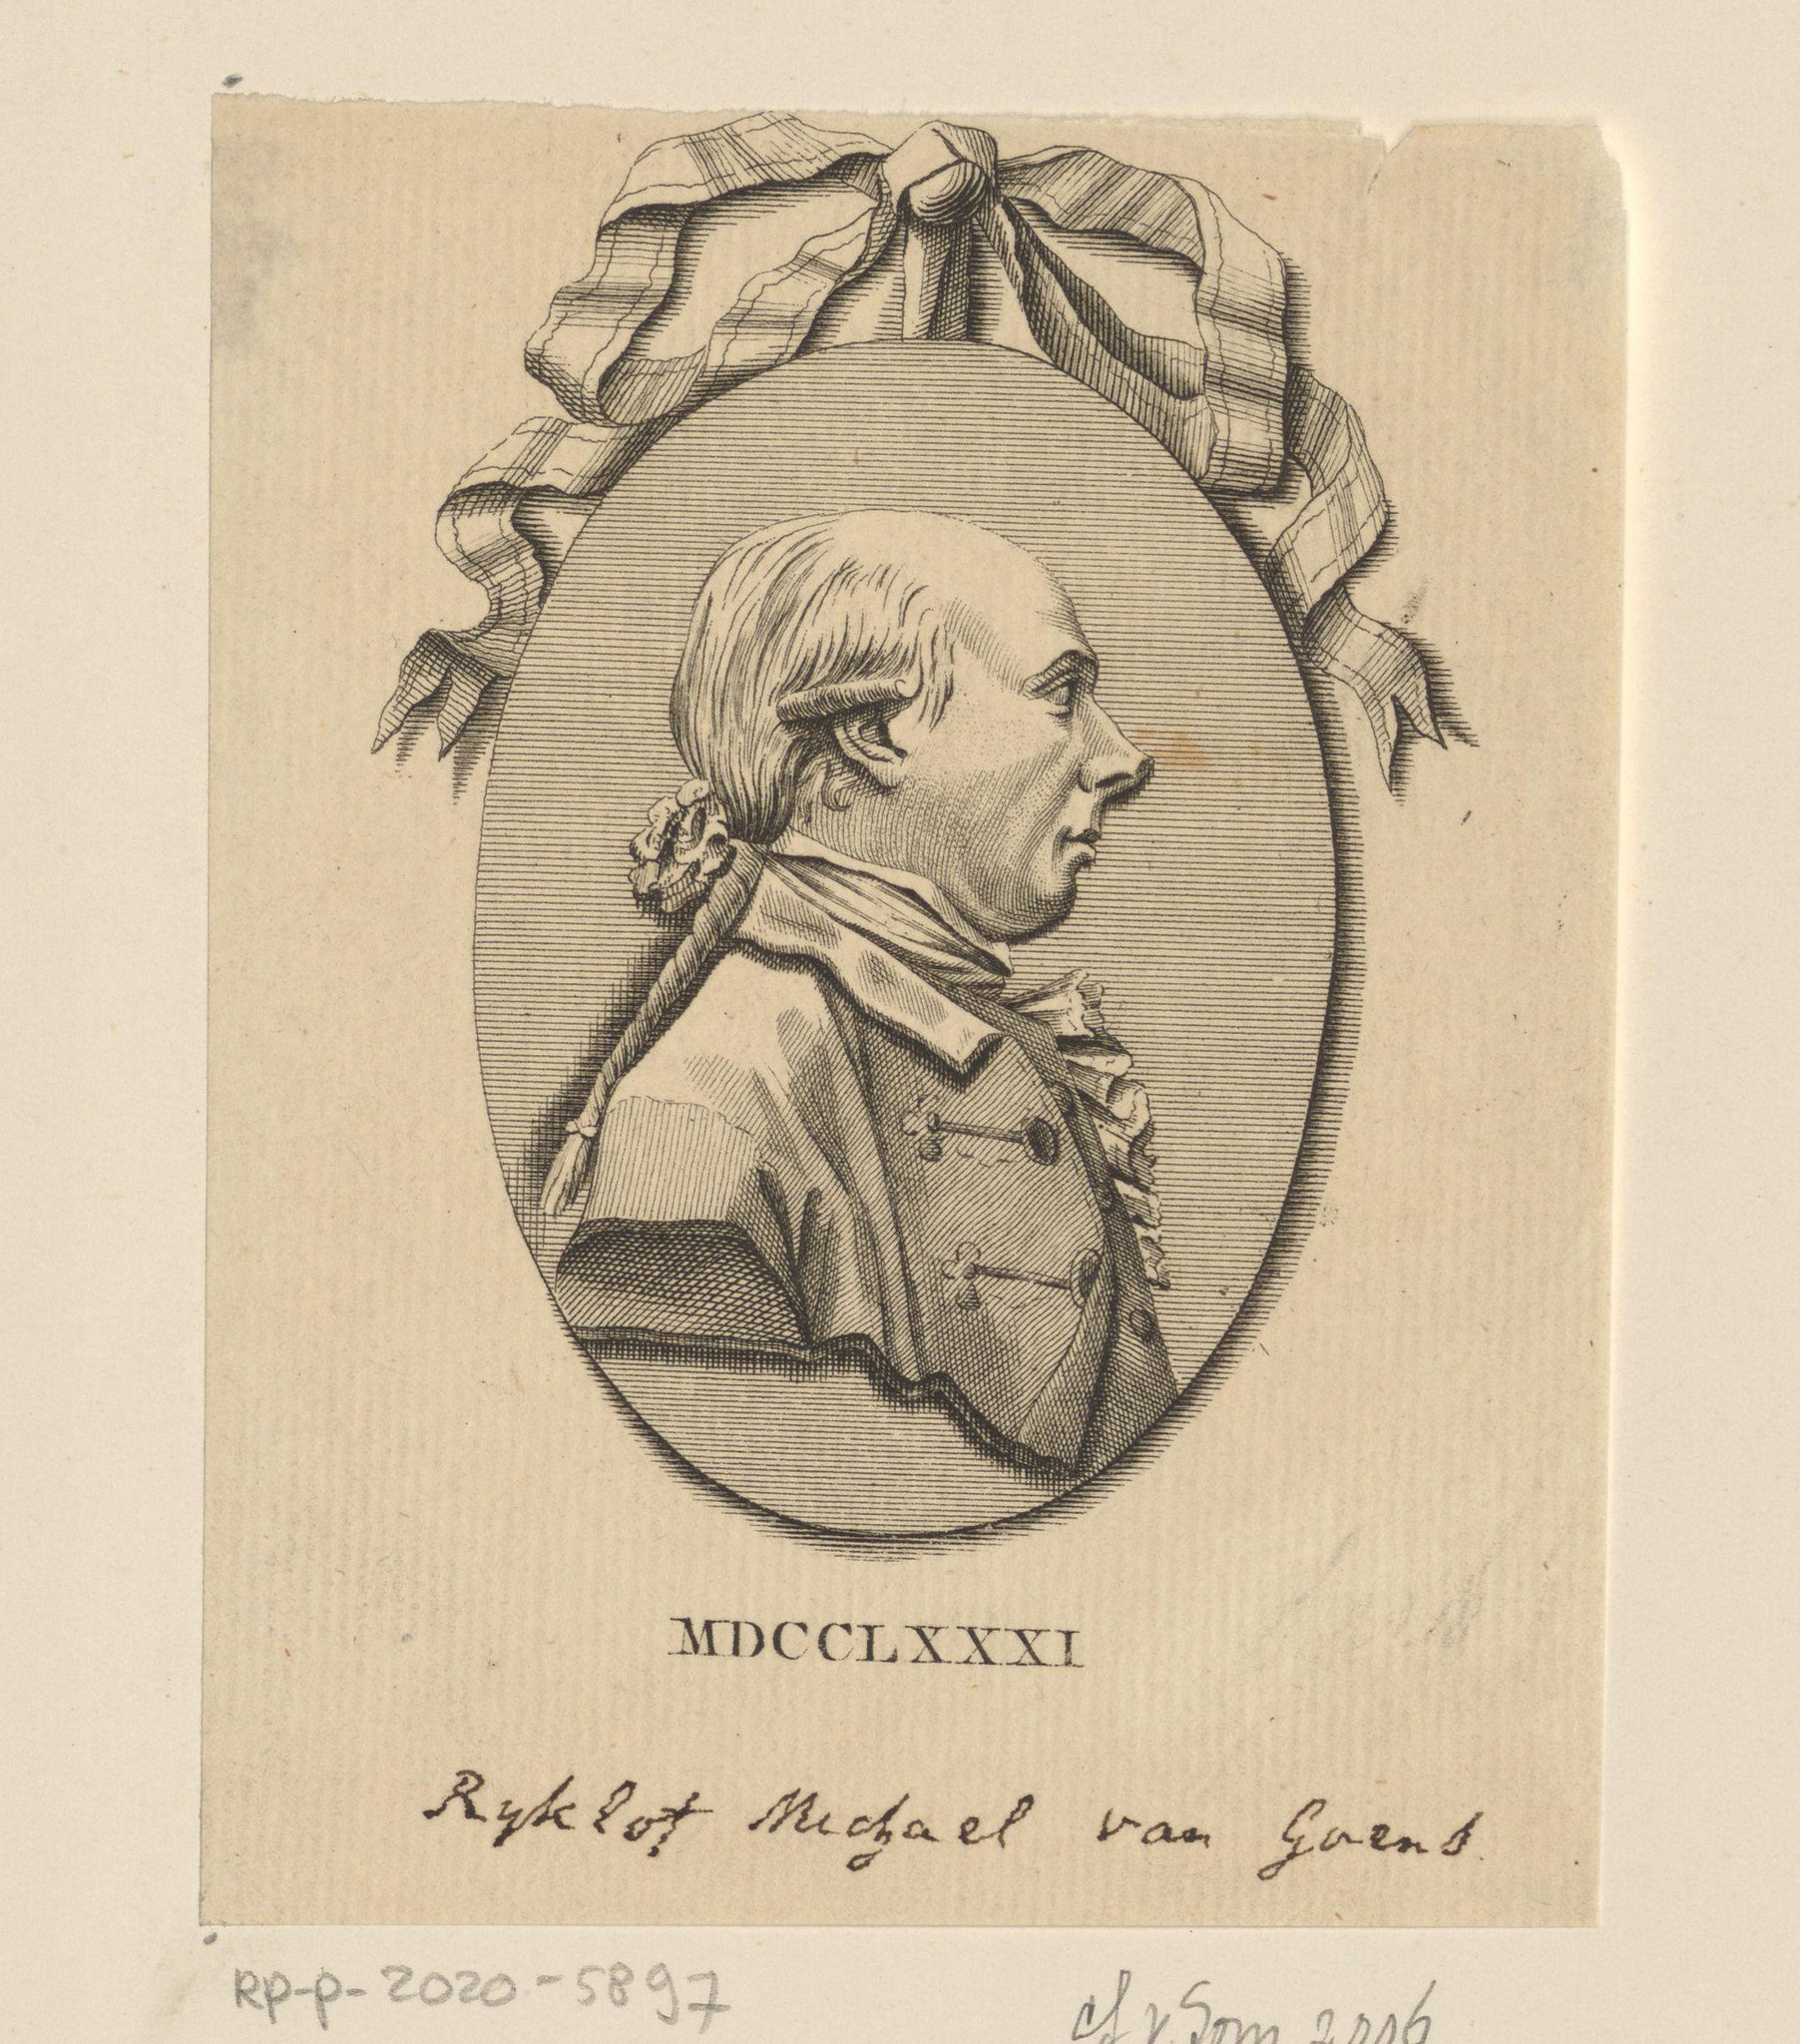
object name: print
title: Portret van Rijklof Michaël van Goens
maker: Anonymous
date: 1781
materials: paper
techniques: etching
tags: utrecht, historical persons, portrait of a writer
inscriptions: inscription: ‘Ryklof Michael van Goens’